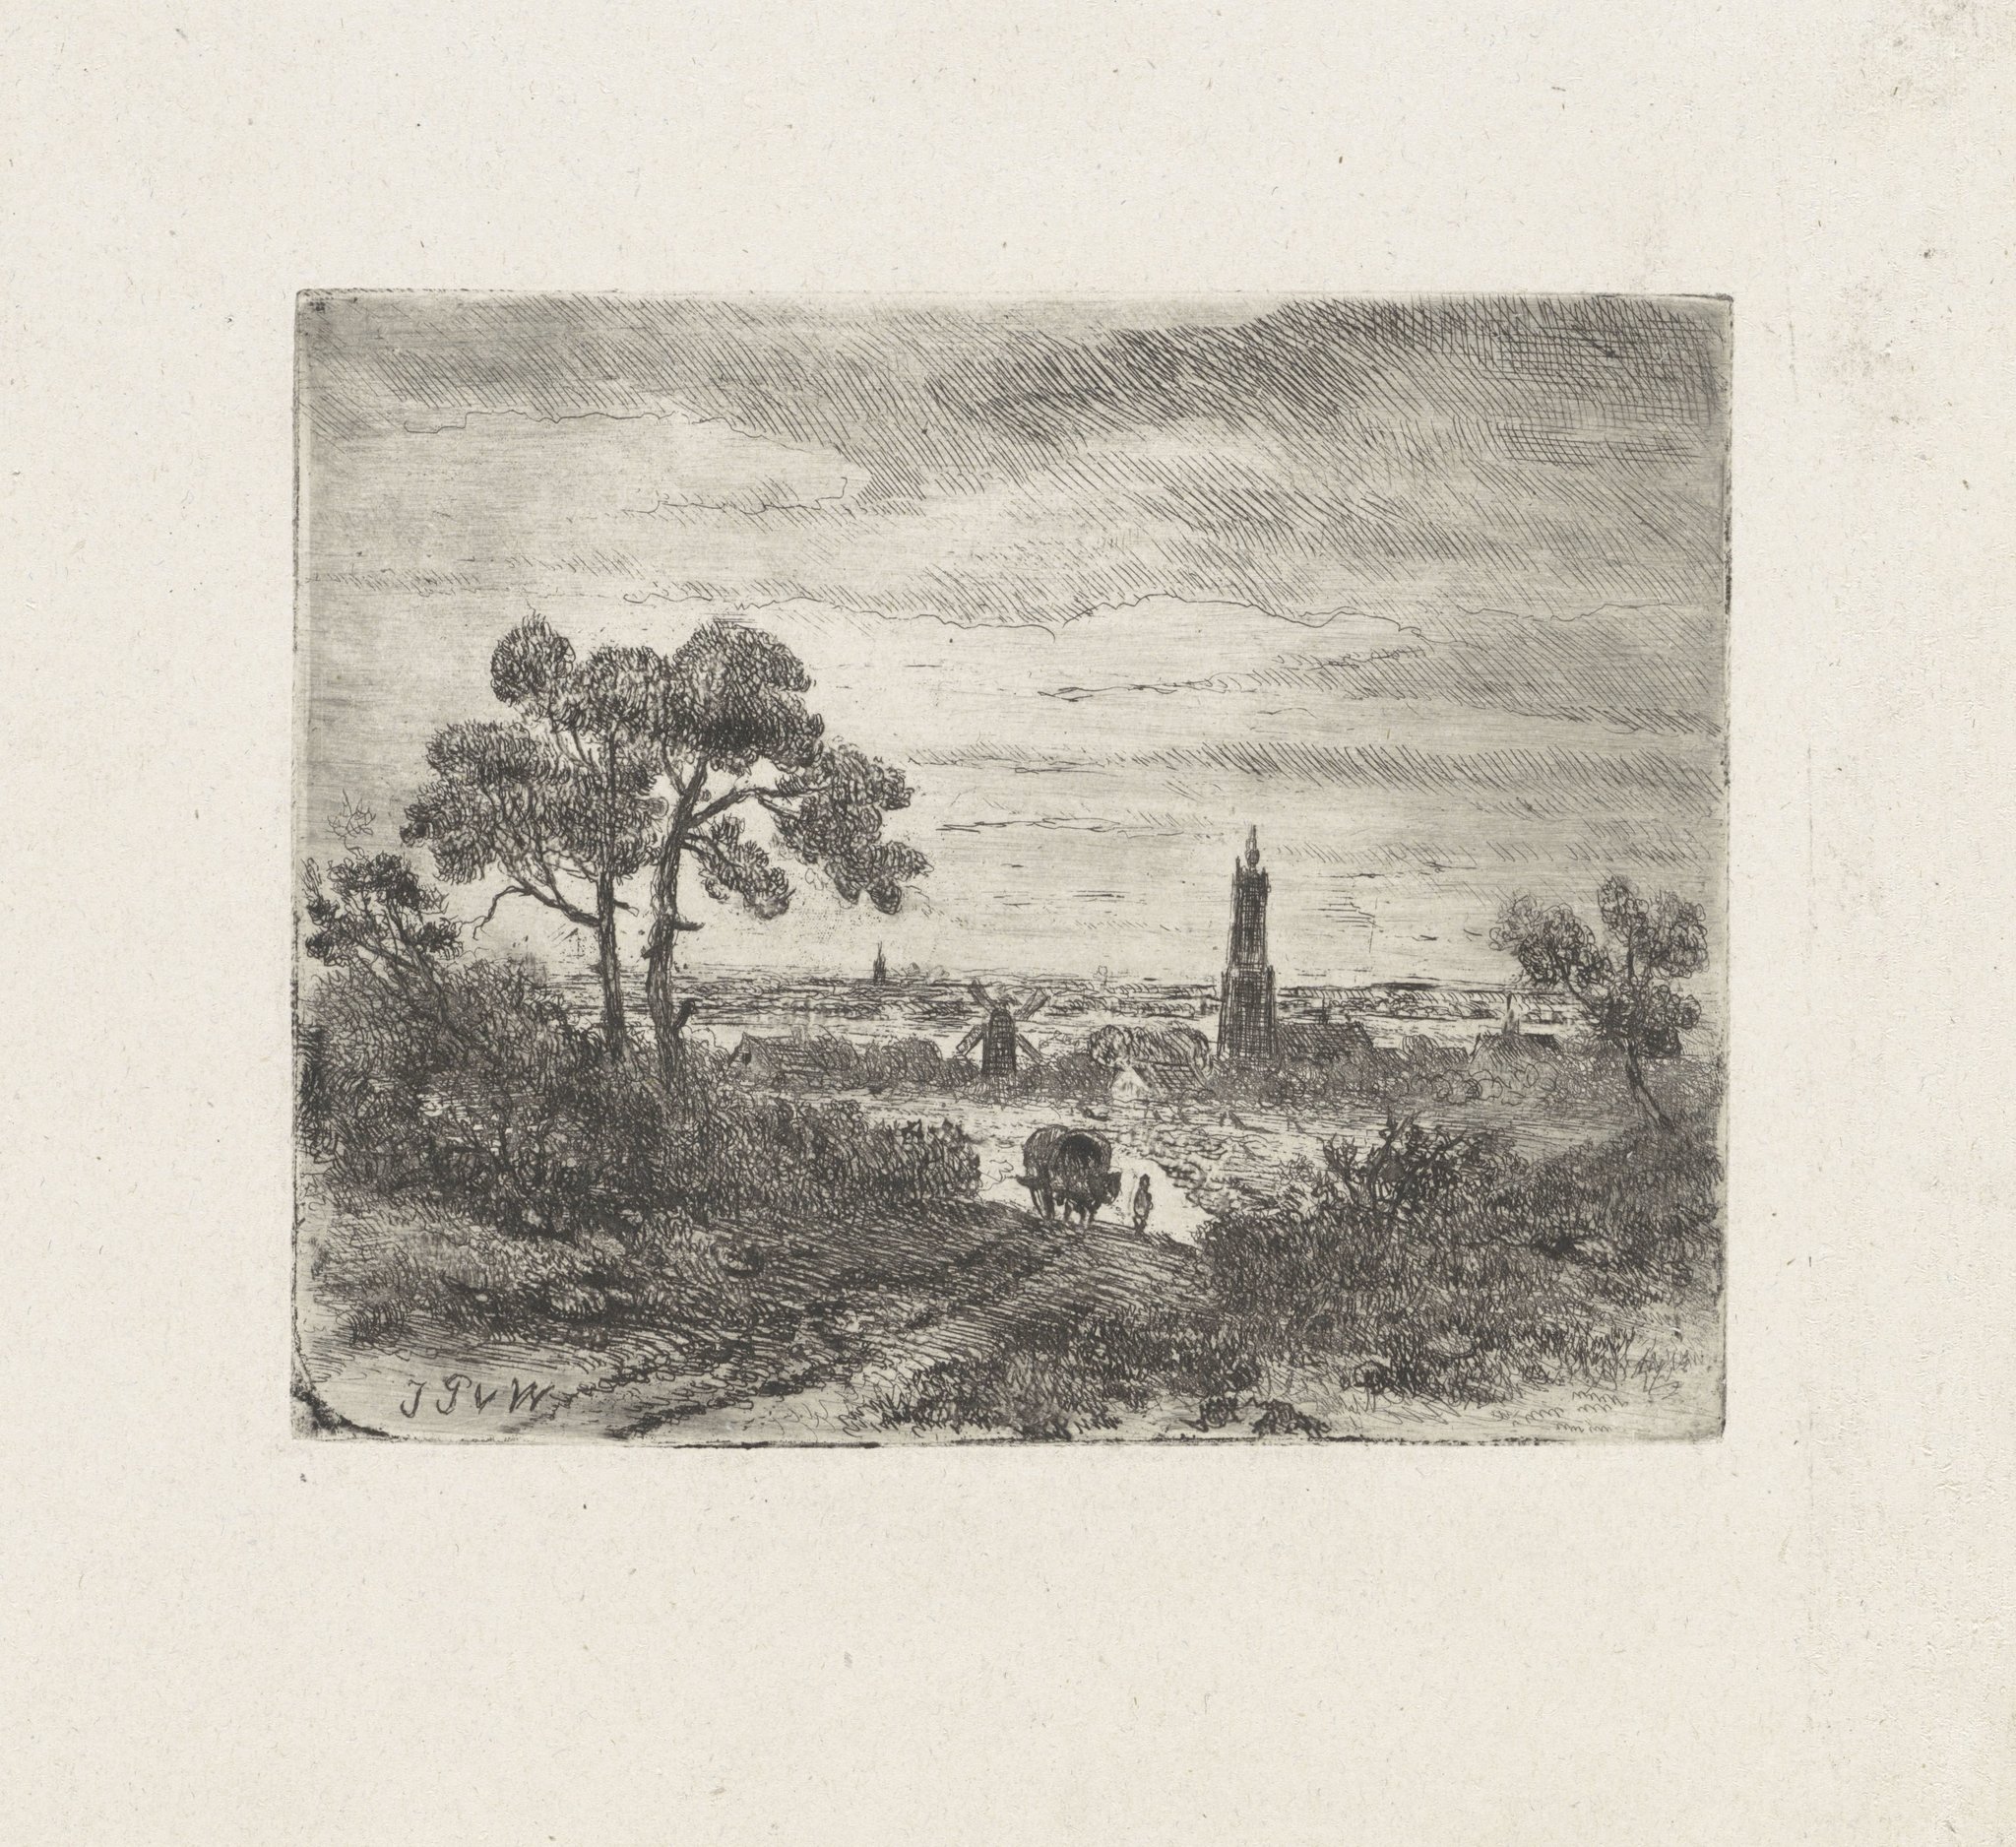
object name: print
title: Gezicht op Rhenen(?)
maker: johannes pieter van wisselingh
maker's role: draughtsman, painter, print maker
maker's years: 1812-1899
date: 1830-1878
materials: paper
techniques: etching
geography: netherlands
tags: city-view, and landscape with man-made constructions, church (exterior), road, path, windmill, (farm) wagon, freight wagon, cart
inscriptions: collector's mark: Lugt 2760, collector's mark: Lugt 2228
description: Gezicht op een stad, Rhenen(?), met een kerk en een molen. Vooraan een paard-en-wagen met een figuur op een landweg.